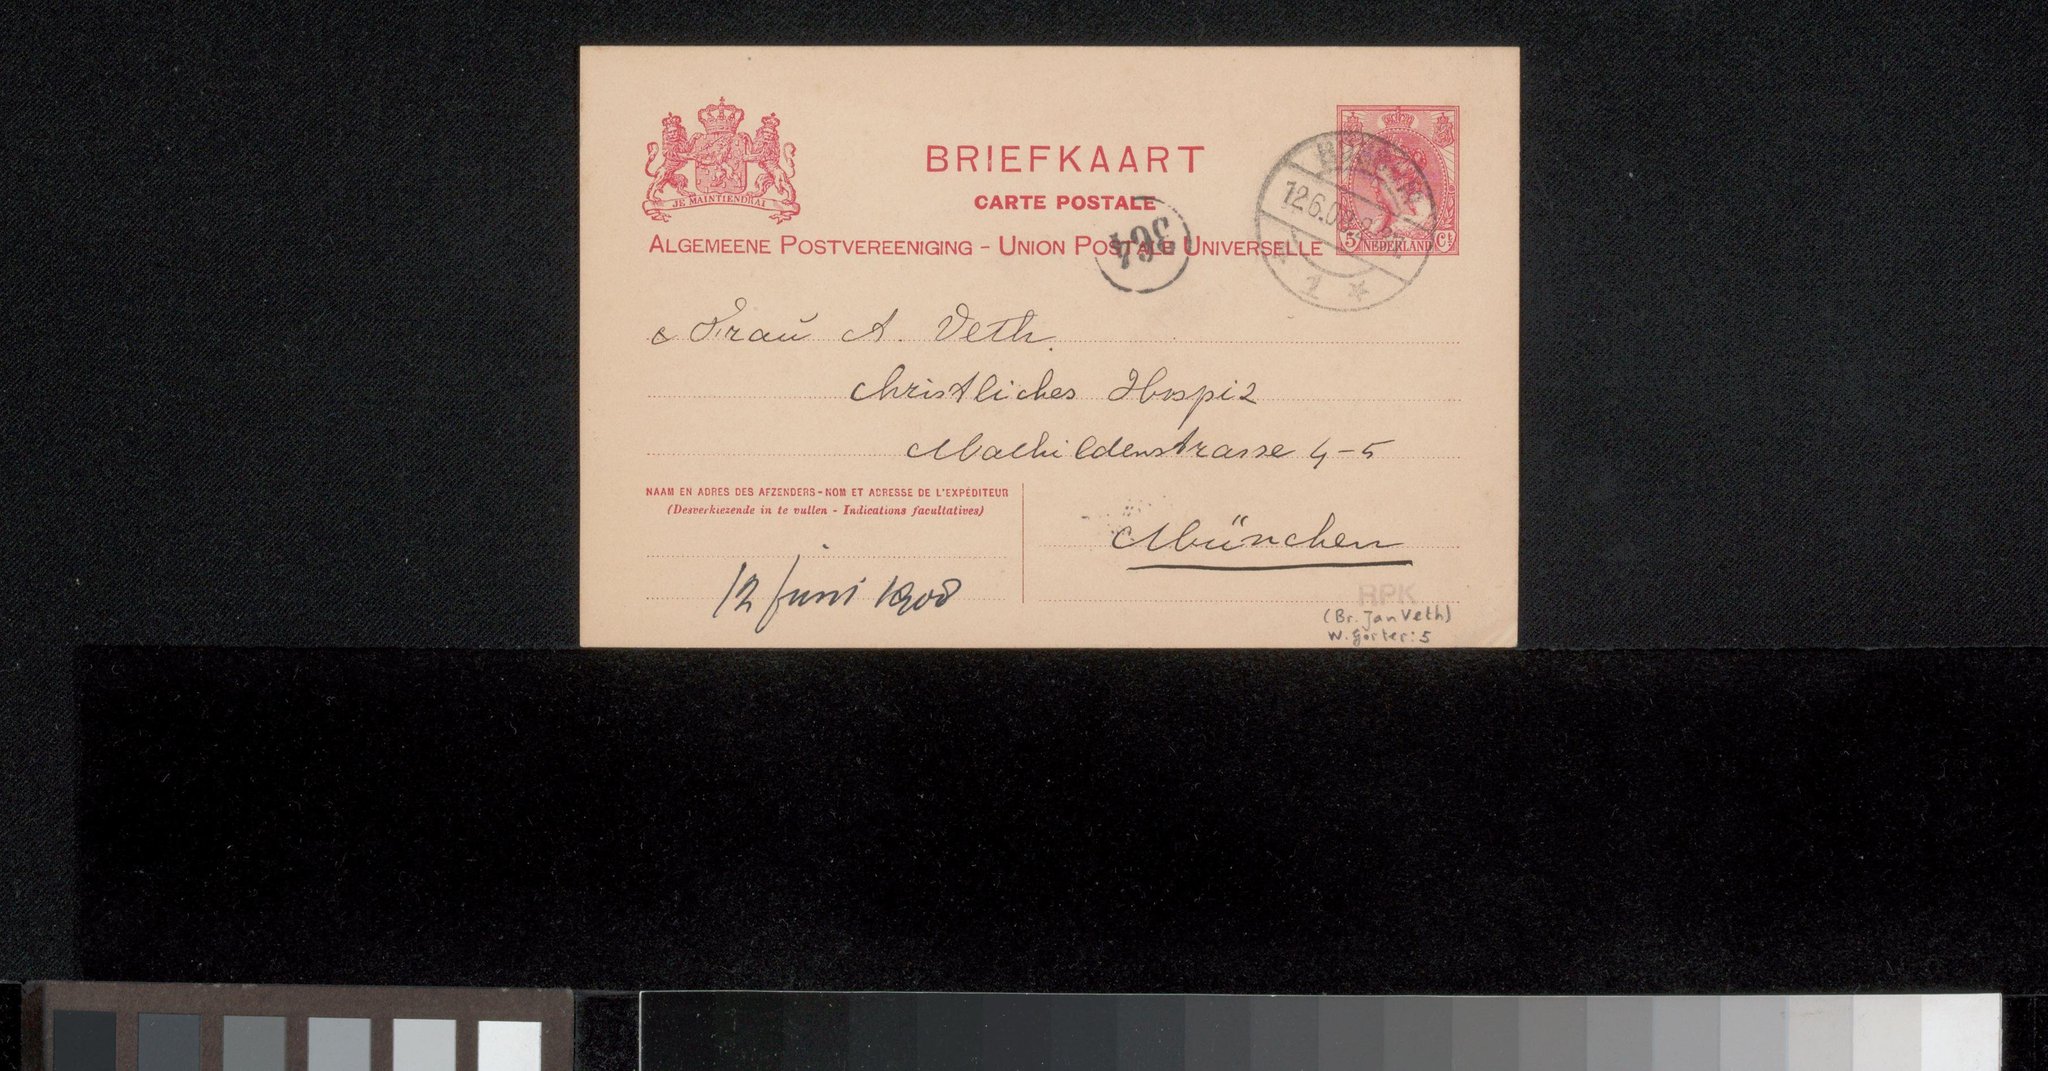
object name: postcard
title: Briefkaart aan Anna Dorothea Dirks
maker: louise catharina gorter-cnoop koopmans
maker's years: 1865-1916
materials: cardboard, ink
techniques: pen, writing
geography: bussum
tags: artist, anna dorothea dirks, family life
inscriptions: collector's mark: ‘RPK’